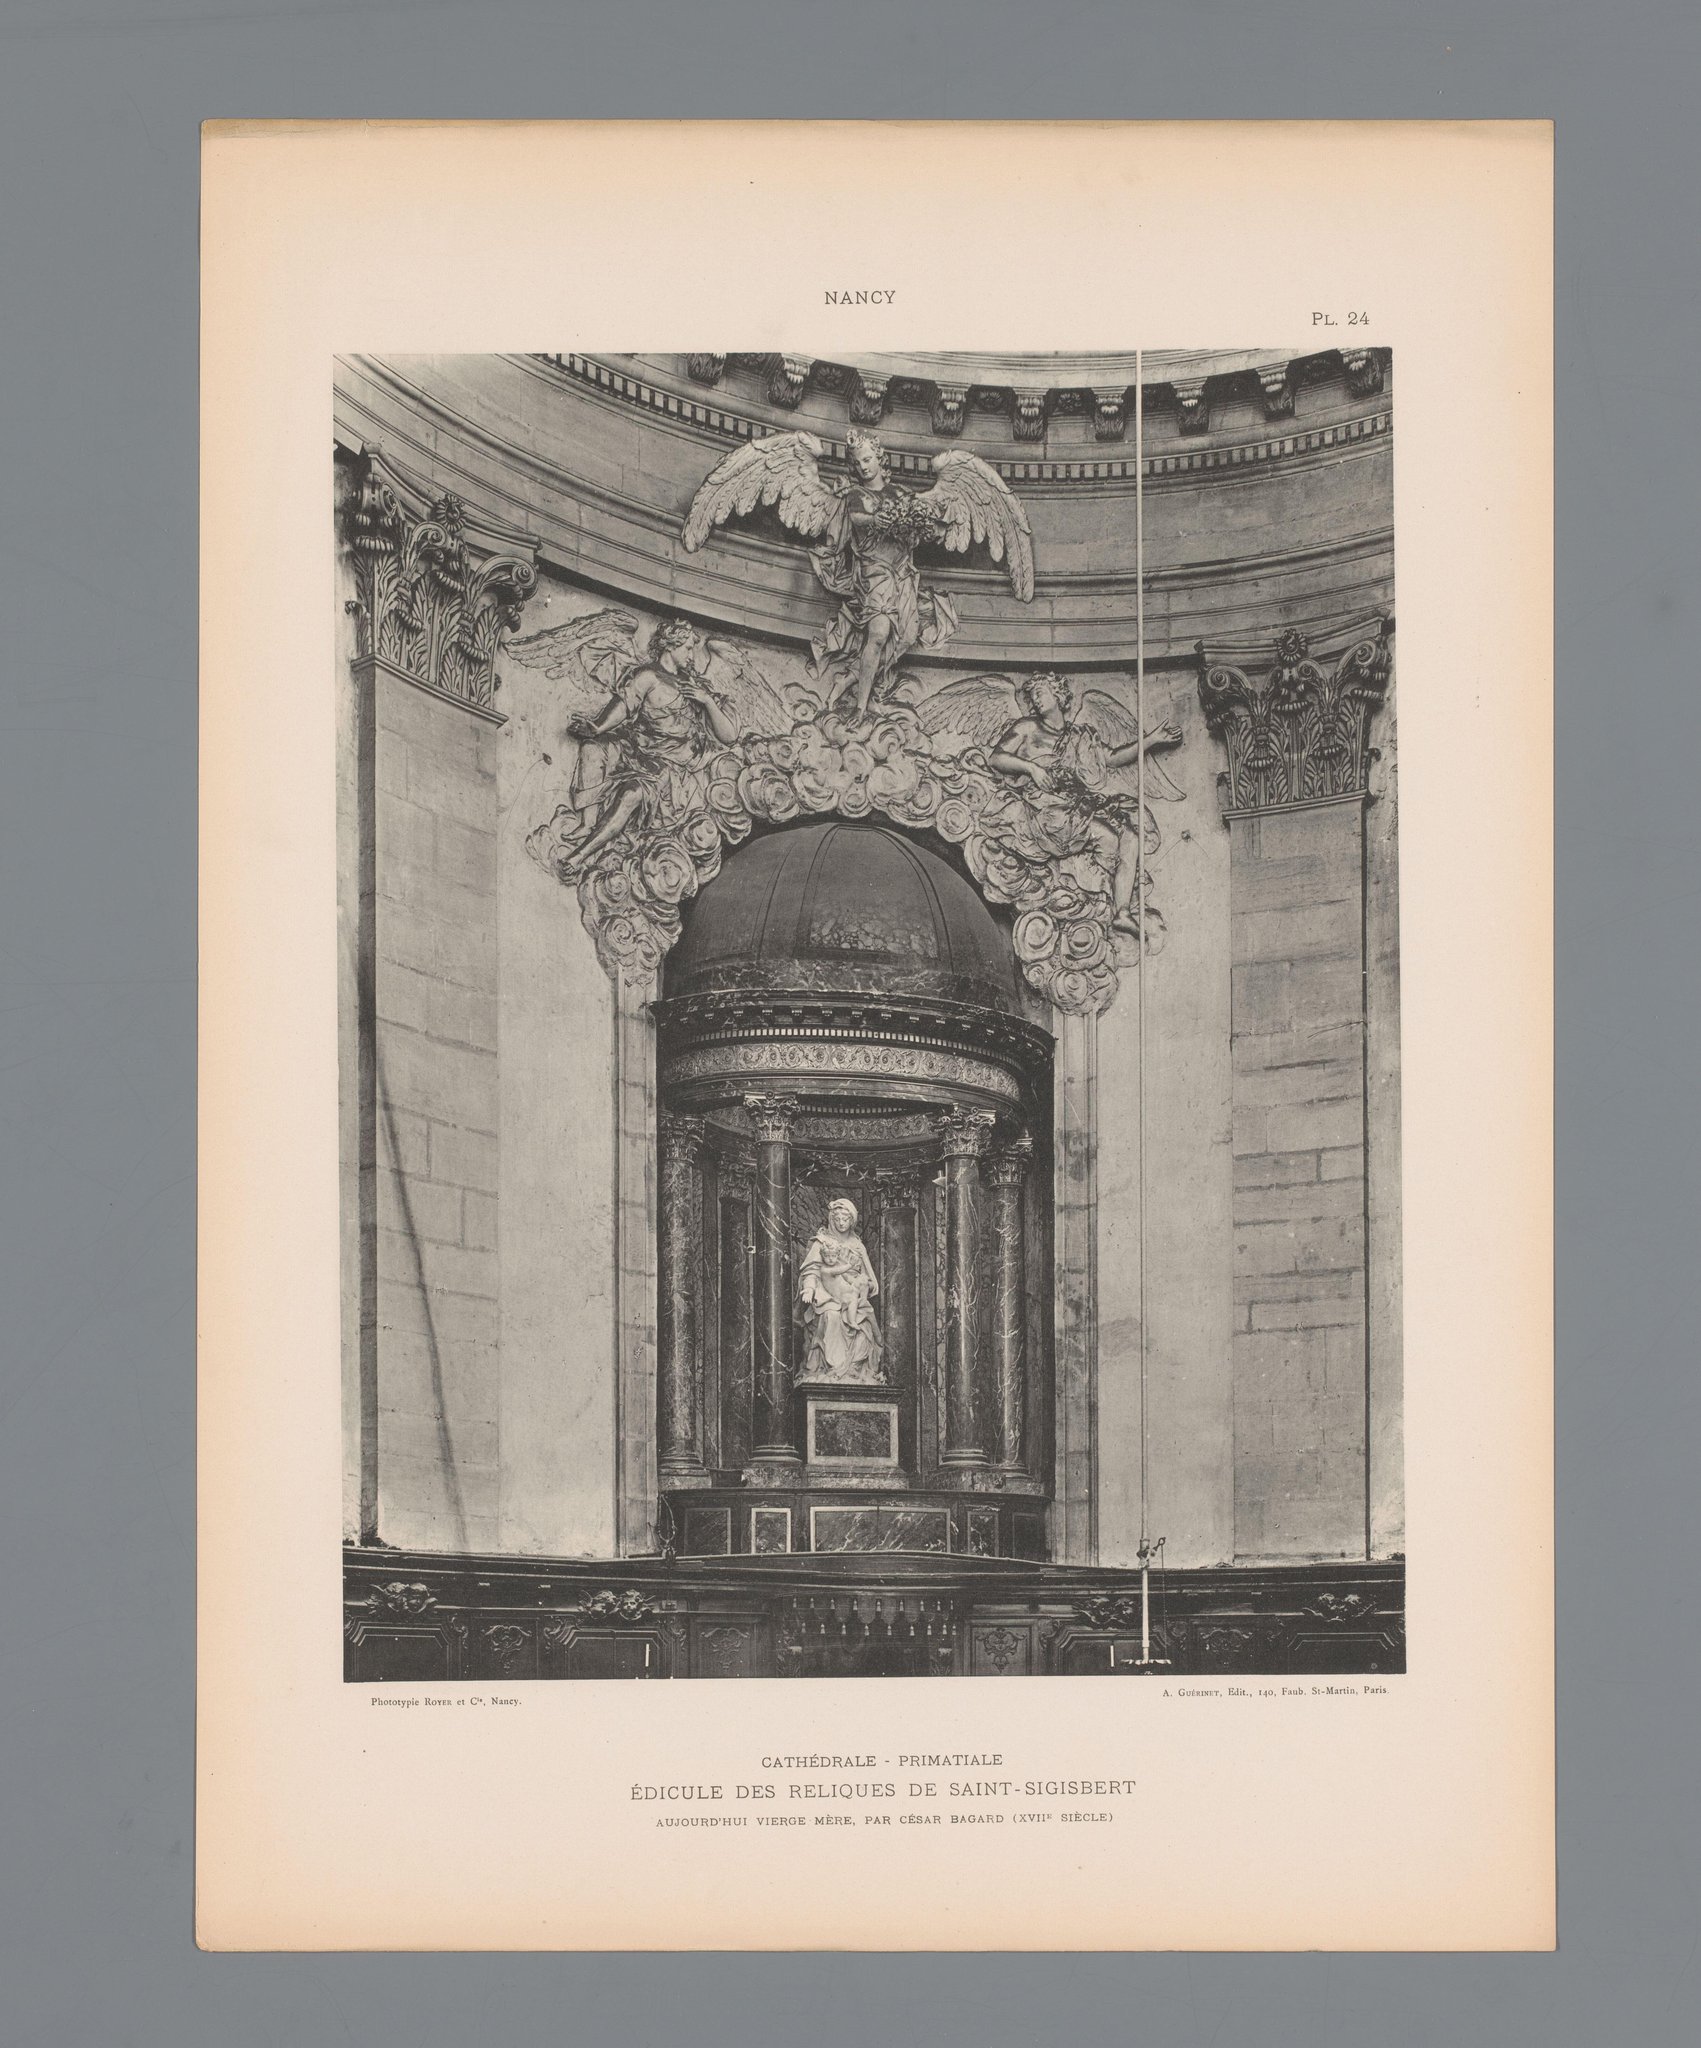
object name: photomechanical print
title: Maria met kind in de Notre-Dame de Saint-Sigisbert te Nancy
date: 1891-1896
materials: paper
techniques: photograph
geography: paris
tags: madonna: i.e. mary with the christ-child, interior of church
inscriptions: inscription: ‘Cathédrale - primatiale/ Édicule des reliques de Saint-Sigisbert (...)’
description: Deze prent maakt deel uit van een omslag met 103 prenten op 101 bladen en een titelblad.